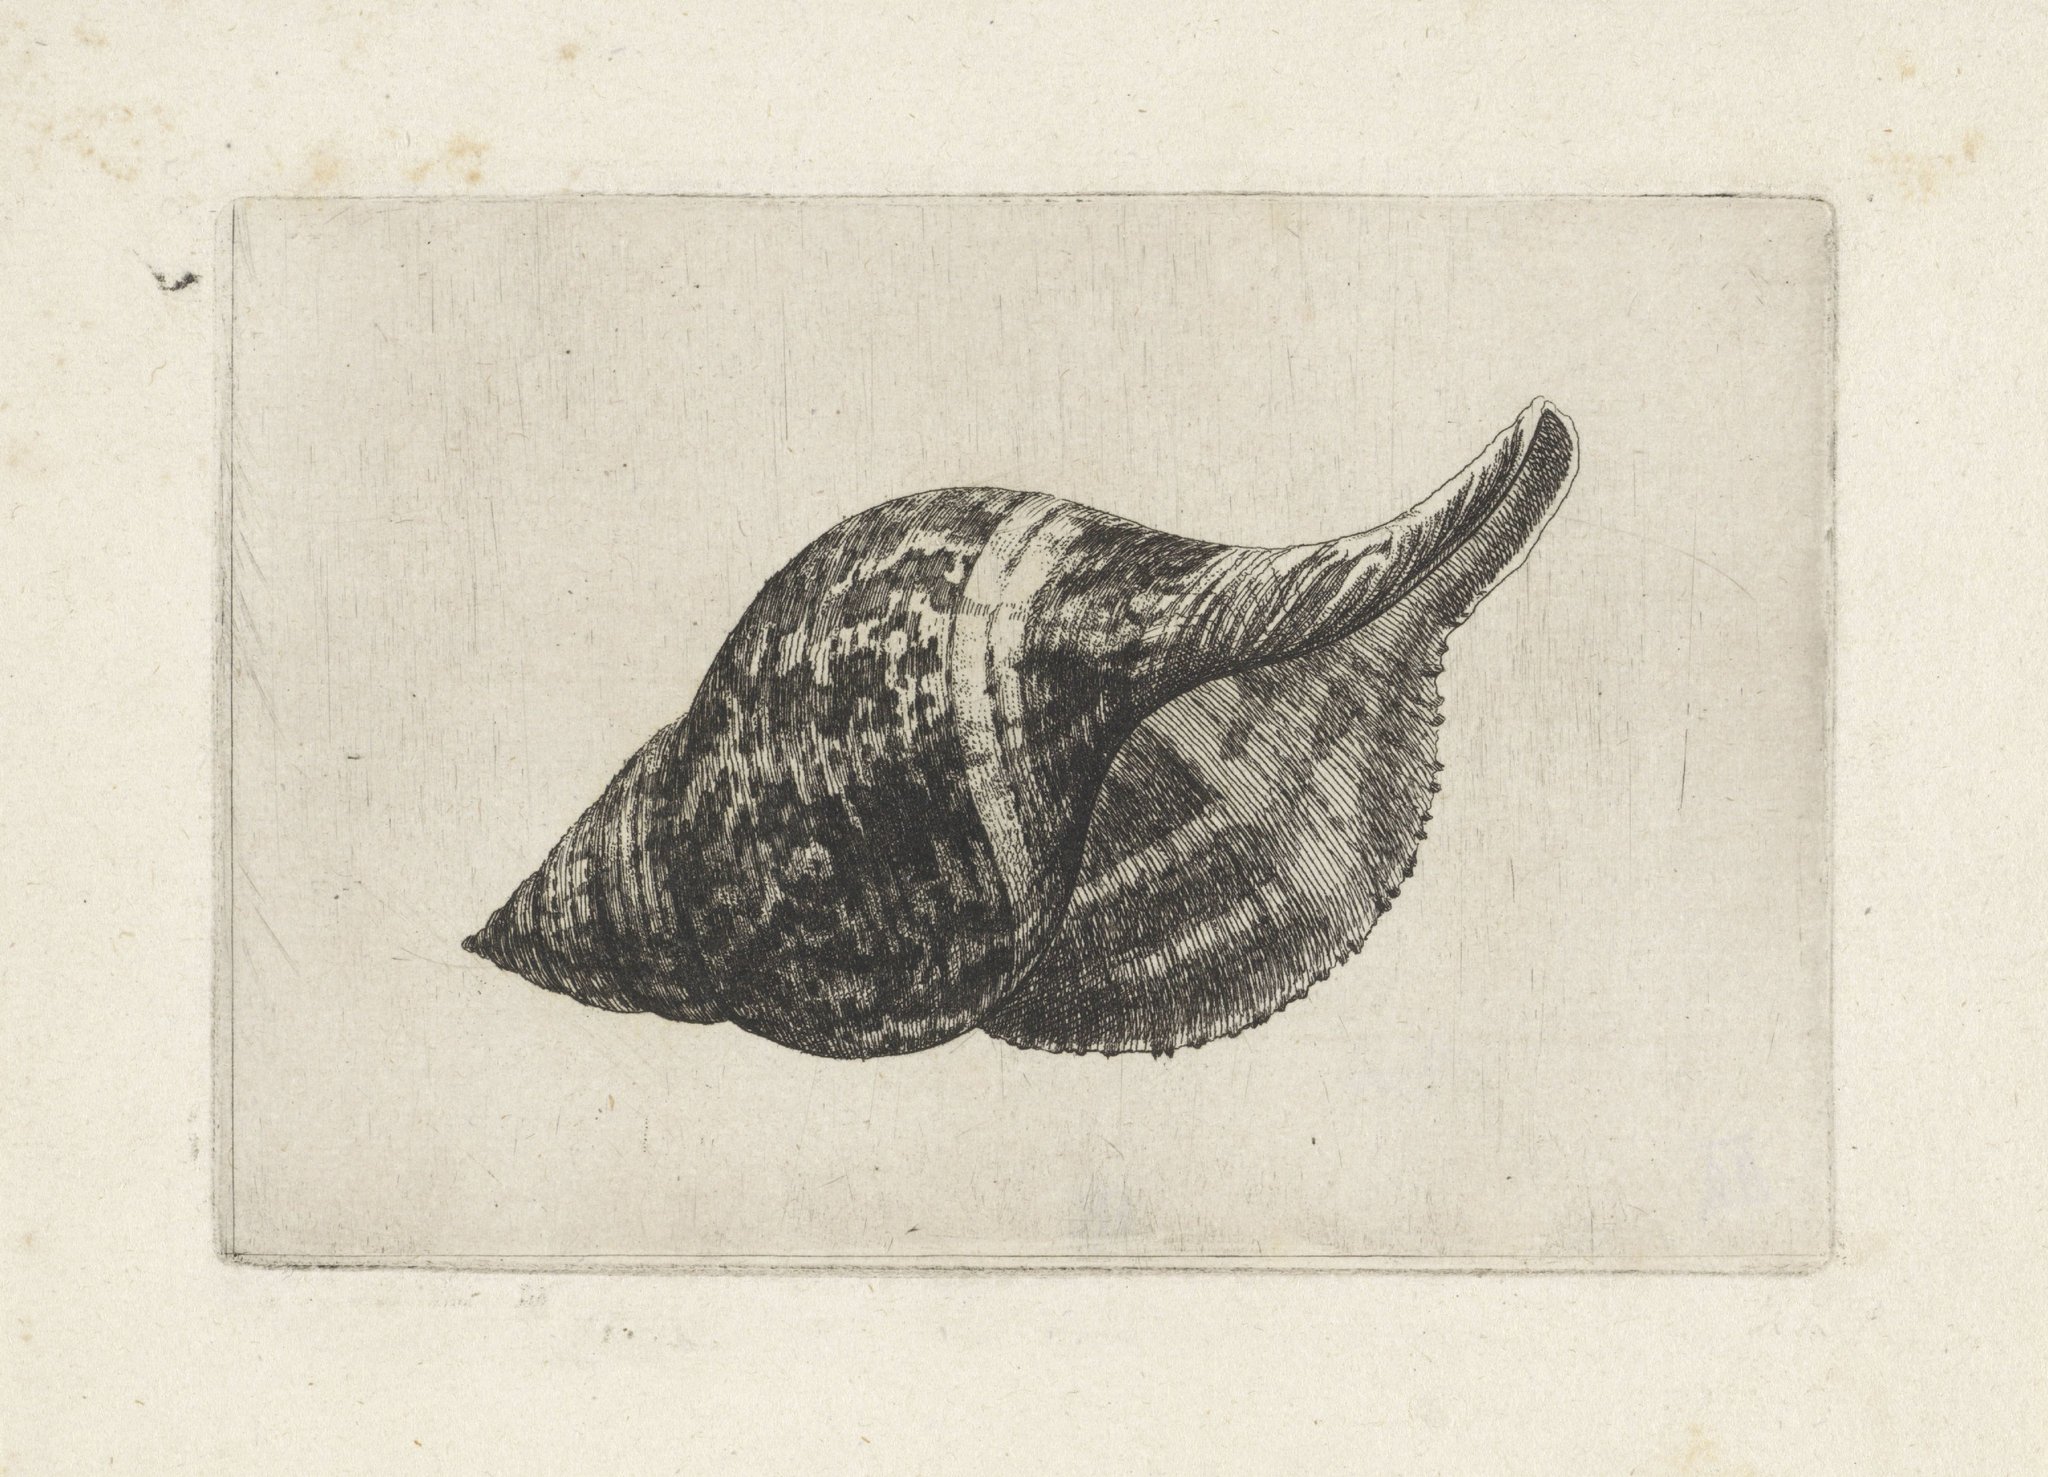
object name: print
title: Schelpen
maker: wenceslaus hollar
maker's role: draughtsman, print maker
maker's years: 1607-1677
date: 1644-1652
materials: paper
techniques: etching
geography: antwerp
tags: molluscs (+ shell, snail-shell etc.)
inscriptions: collector's mark: Lugt 384, collector's mark: Lugt 654, collector's mark: Lugt 68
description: Prent maakt deel uit van een 39-delige serie met verschillende soorten schelpen.